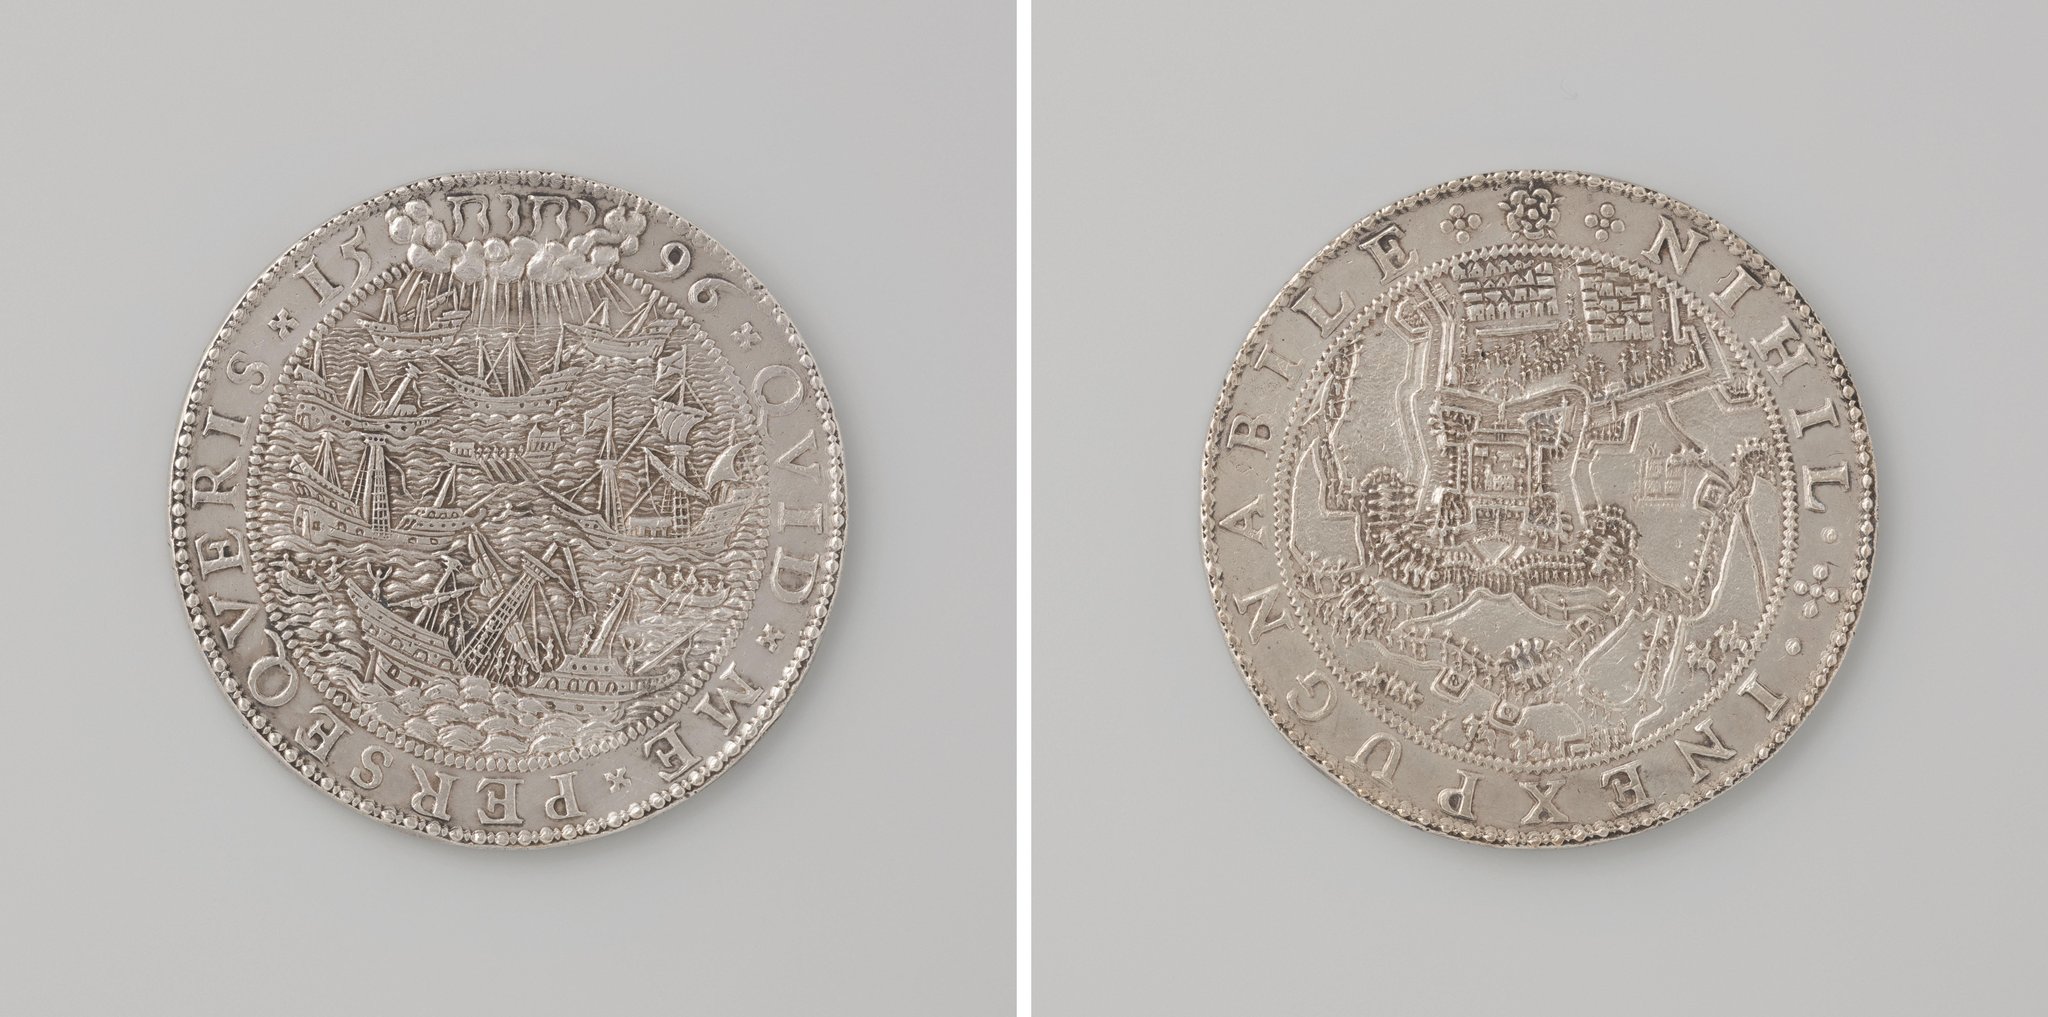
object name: history medal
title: Vergaan van de Spaanse vloot bij Kaap Finistere en verovering van Gulik door prins Maurits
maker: gerard van bylaer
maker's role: die cutter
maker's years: 1540-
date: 1610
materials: silver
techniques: striking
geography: dordrecht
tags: the hague, maurice (prince of orange)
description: Zilveren penning. Voorzijde: vergaan van schepen binnen omschrift. Keerzijde: plattegrond van belegerde vesting (Gulik) binnen omschrift